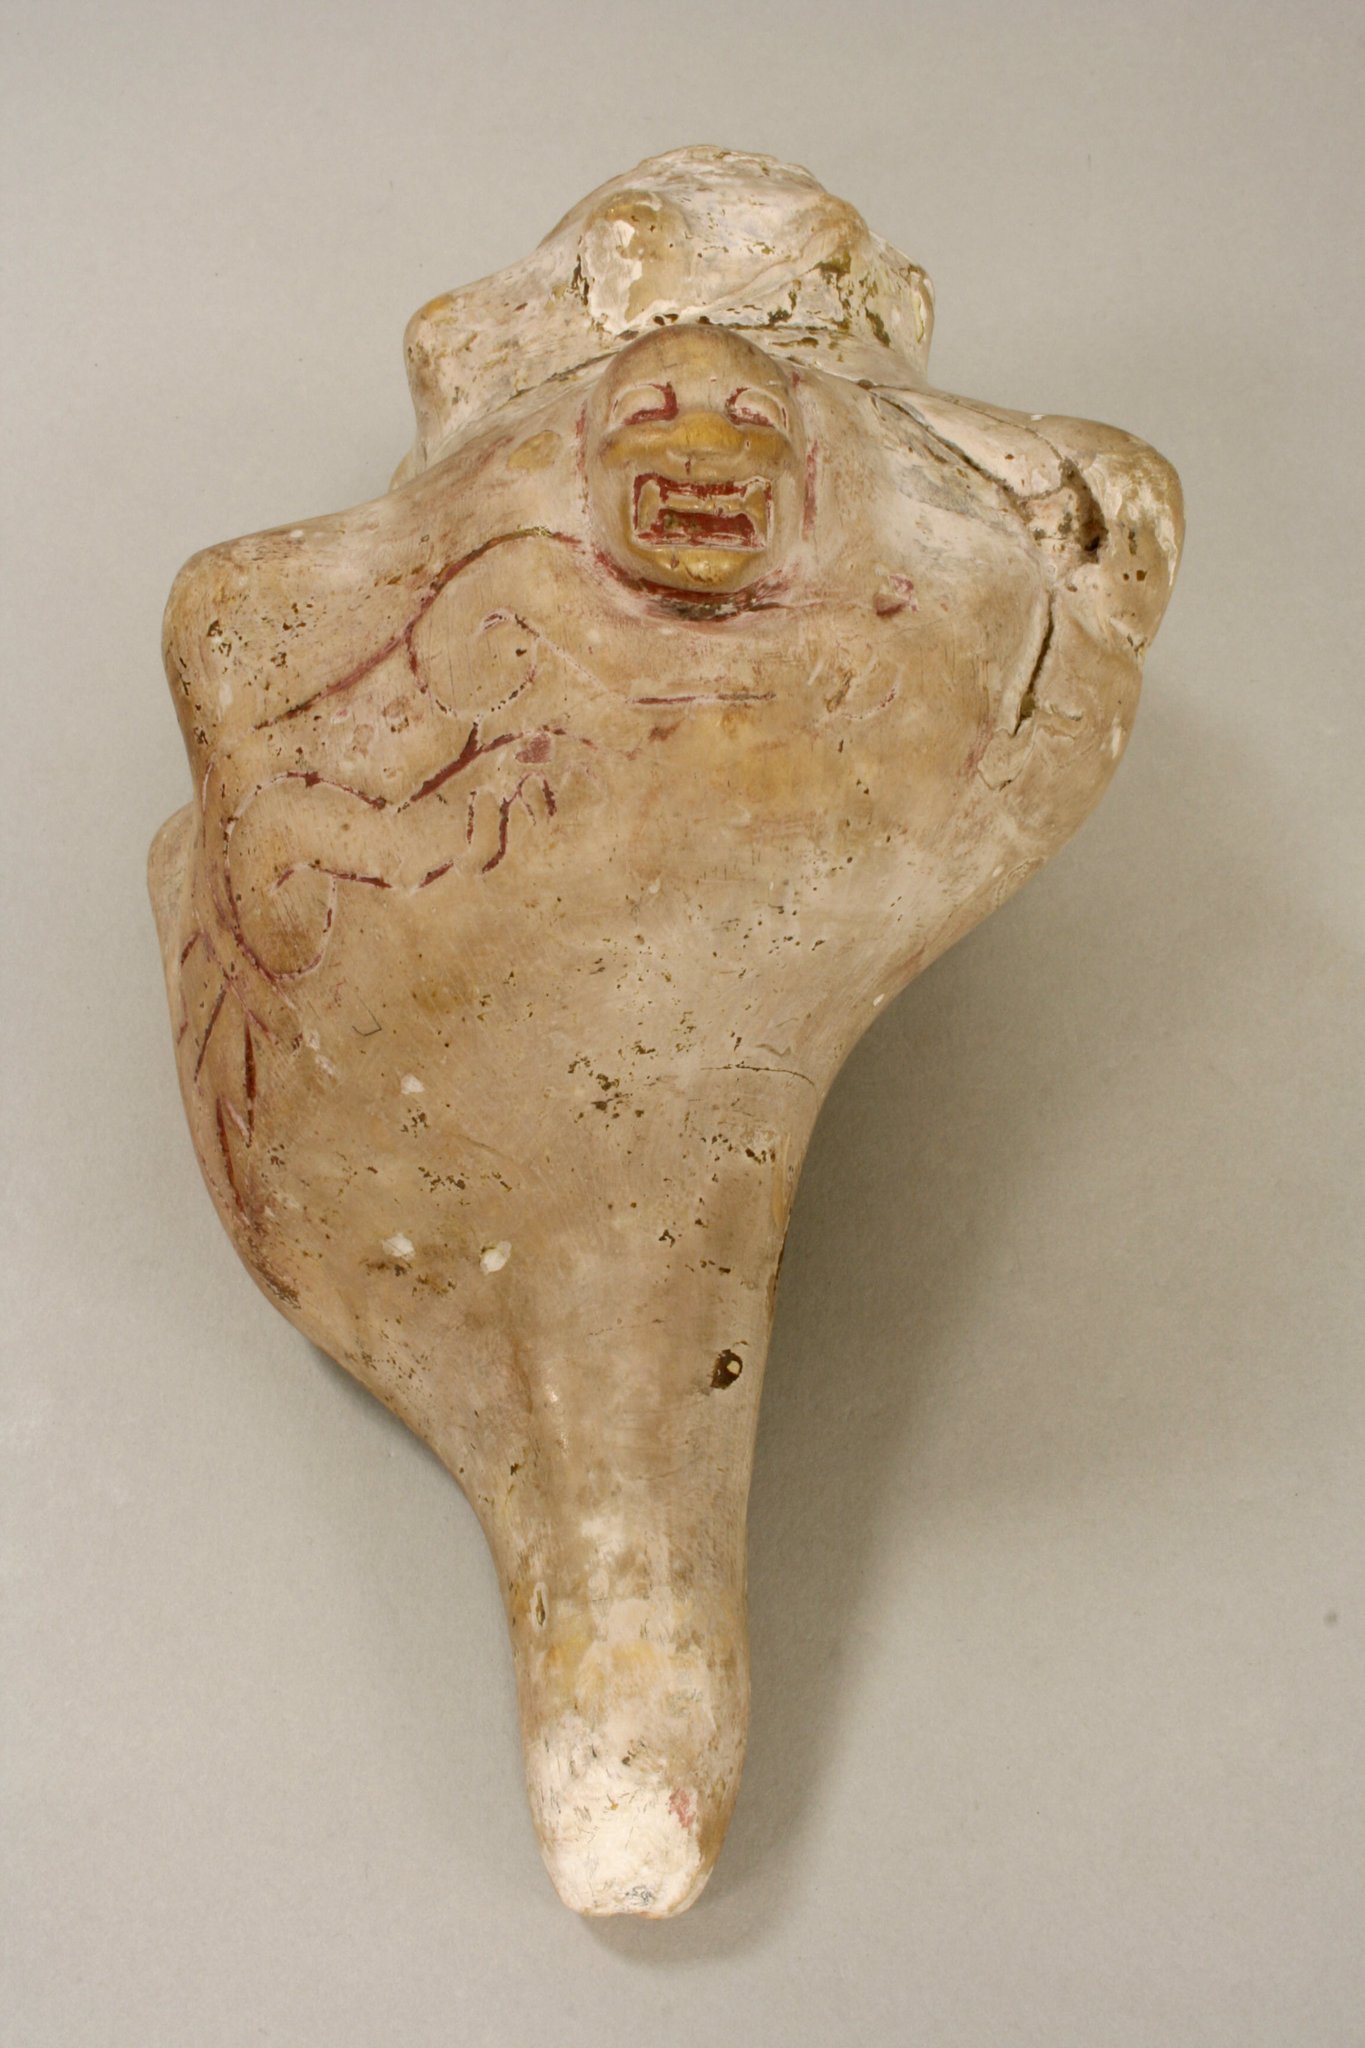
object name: conch shell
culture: monte alban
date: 200 BCE-400 CE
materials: shell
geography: mexico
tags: heads